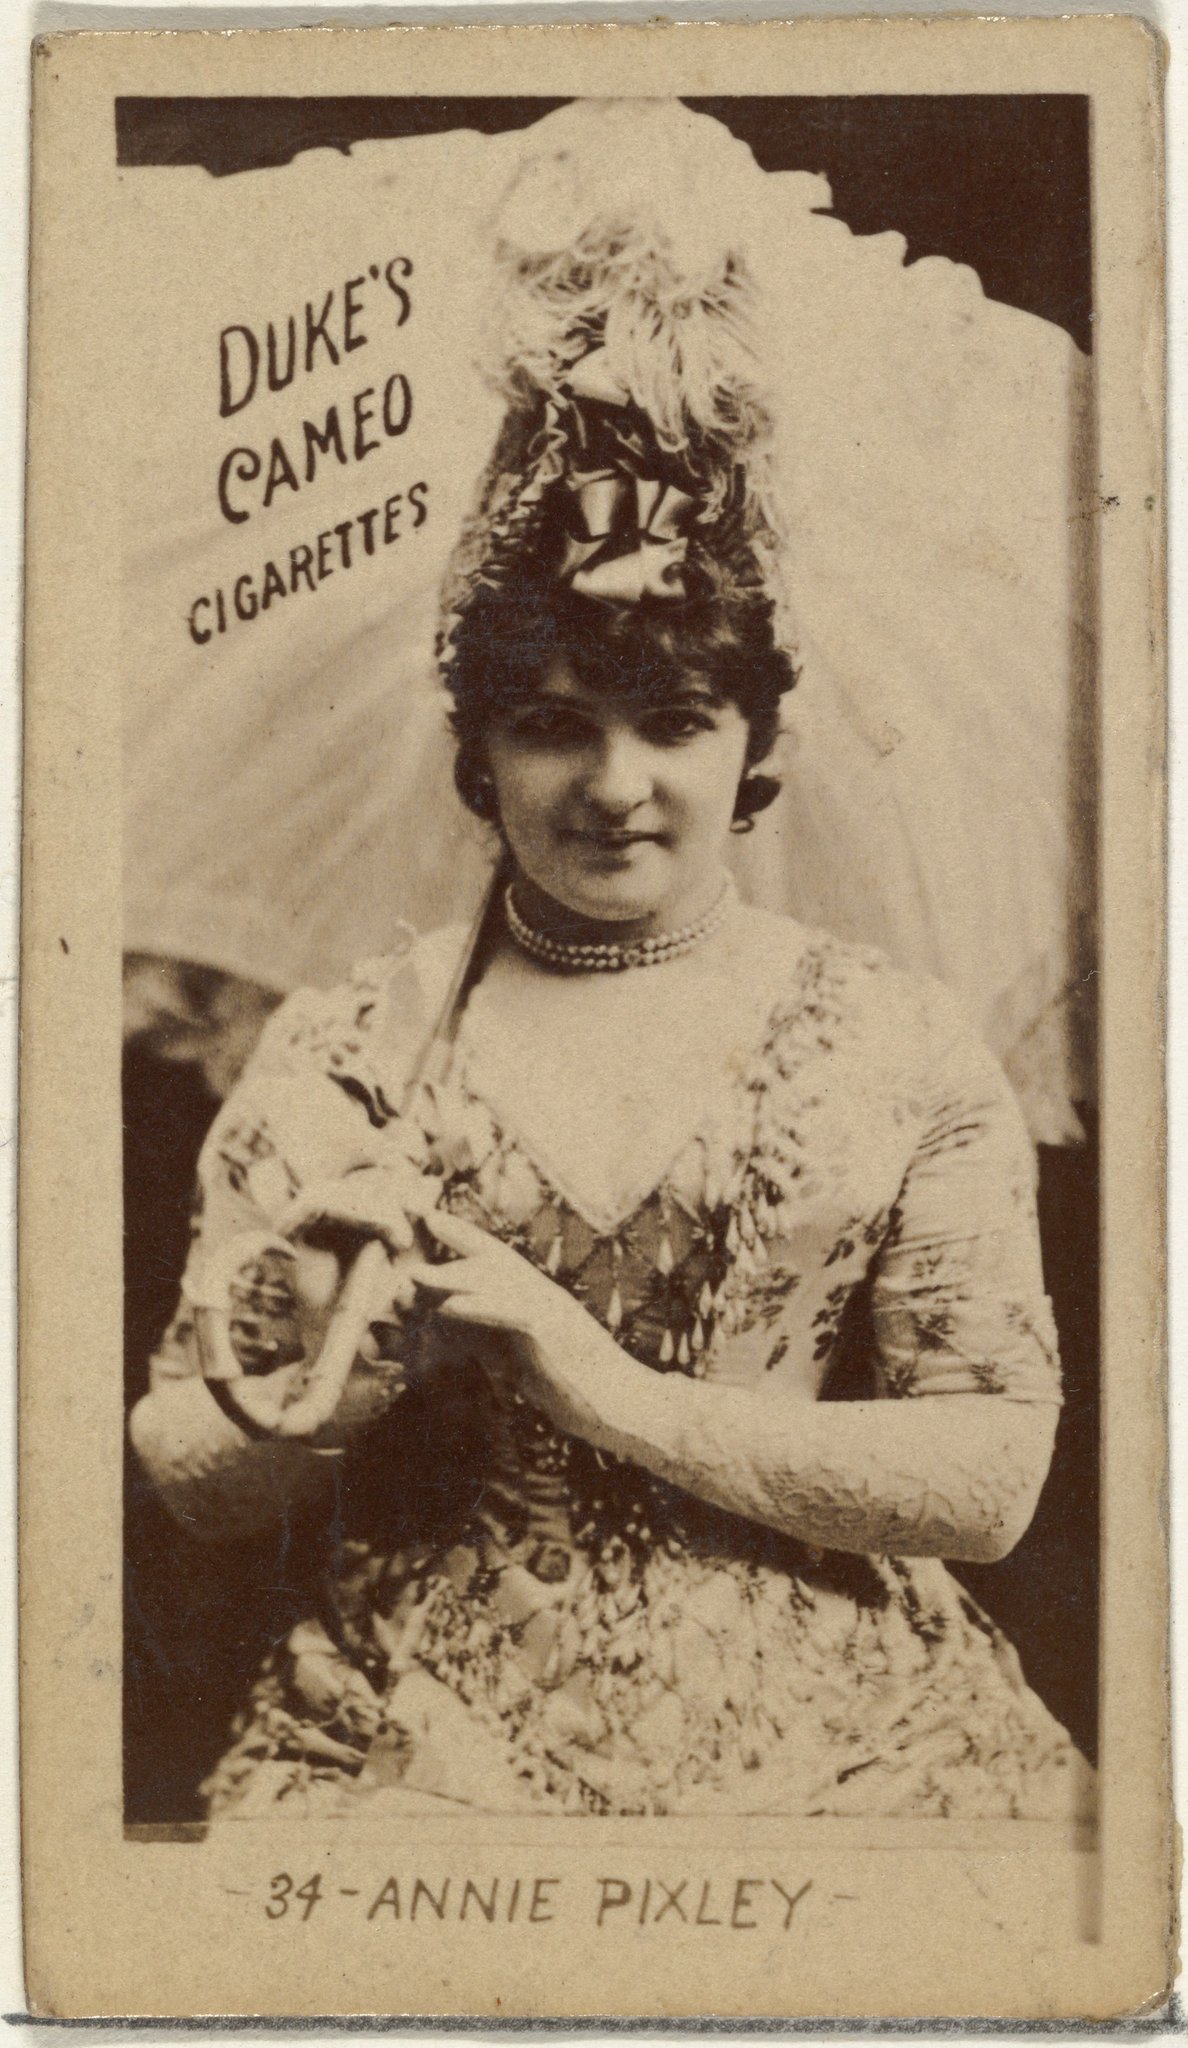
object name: photograph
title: Card Number 34, Annie Pixley, from the Actors and Actresses series (N145-4) issued by Duke Sons & Co. to promote Cameo Cigarettes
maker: w. duke, sons & co.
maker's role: publisher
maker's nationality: american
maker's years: 1870-1920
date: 1880-1889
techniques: albumen silver print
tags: portraits,women,actresses